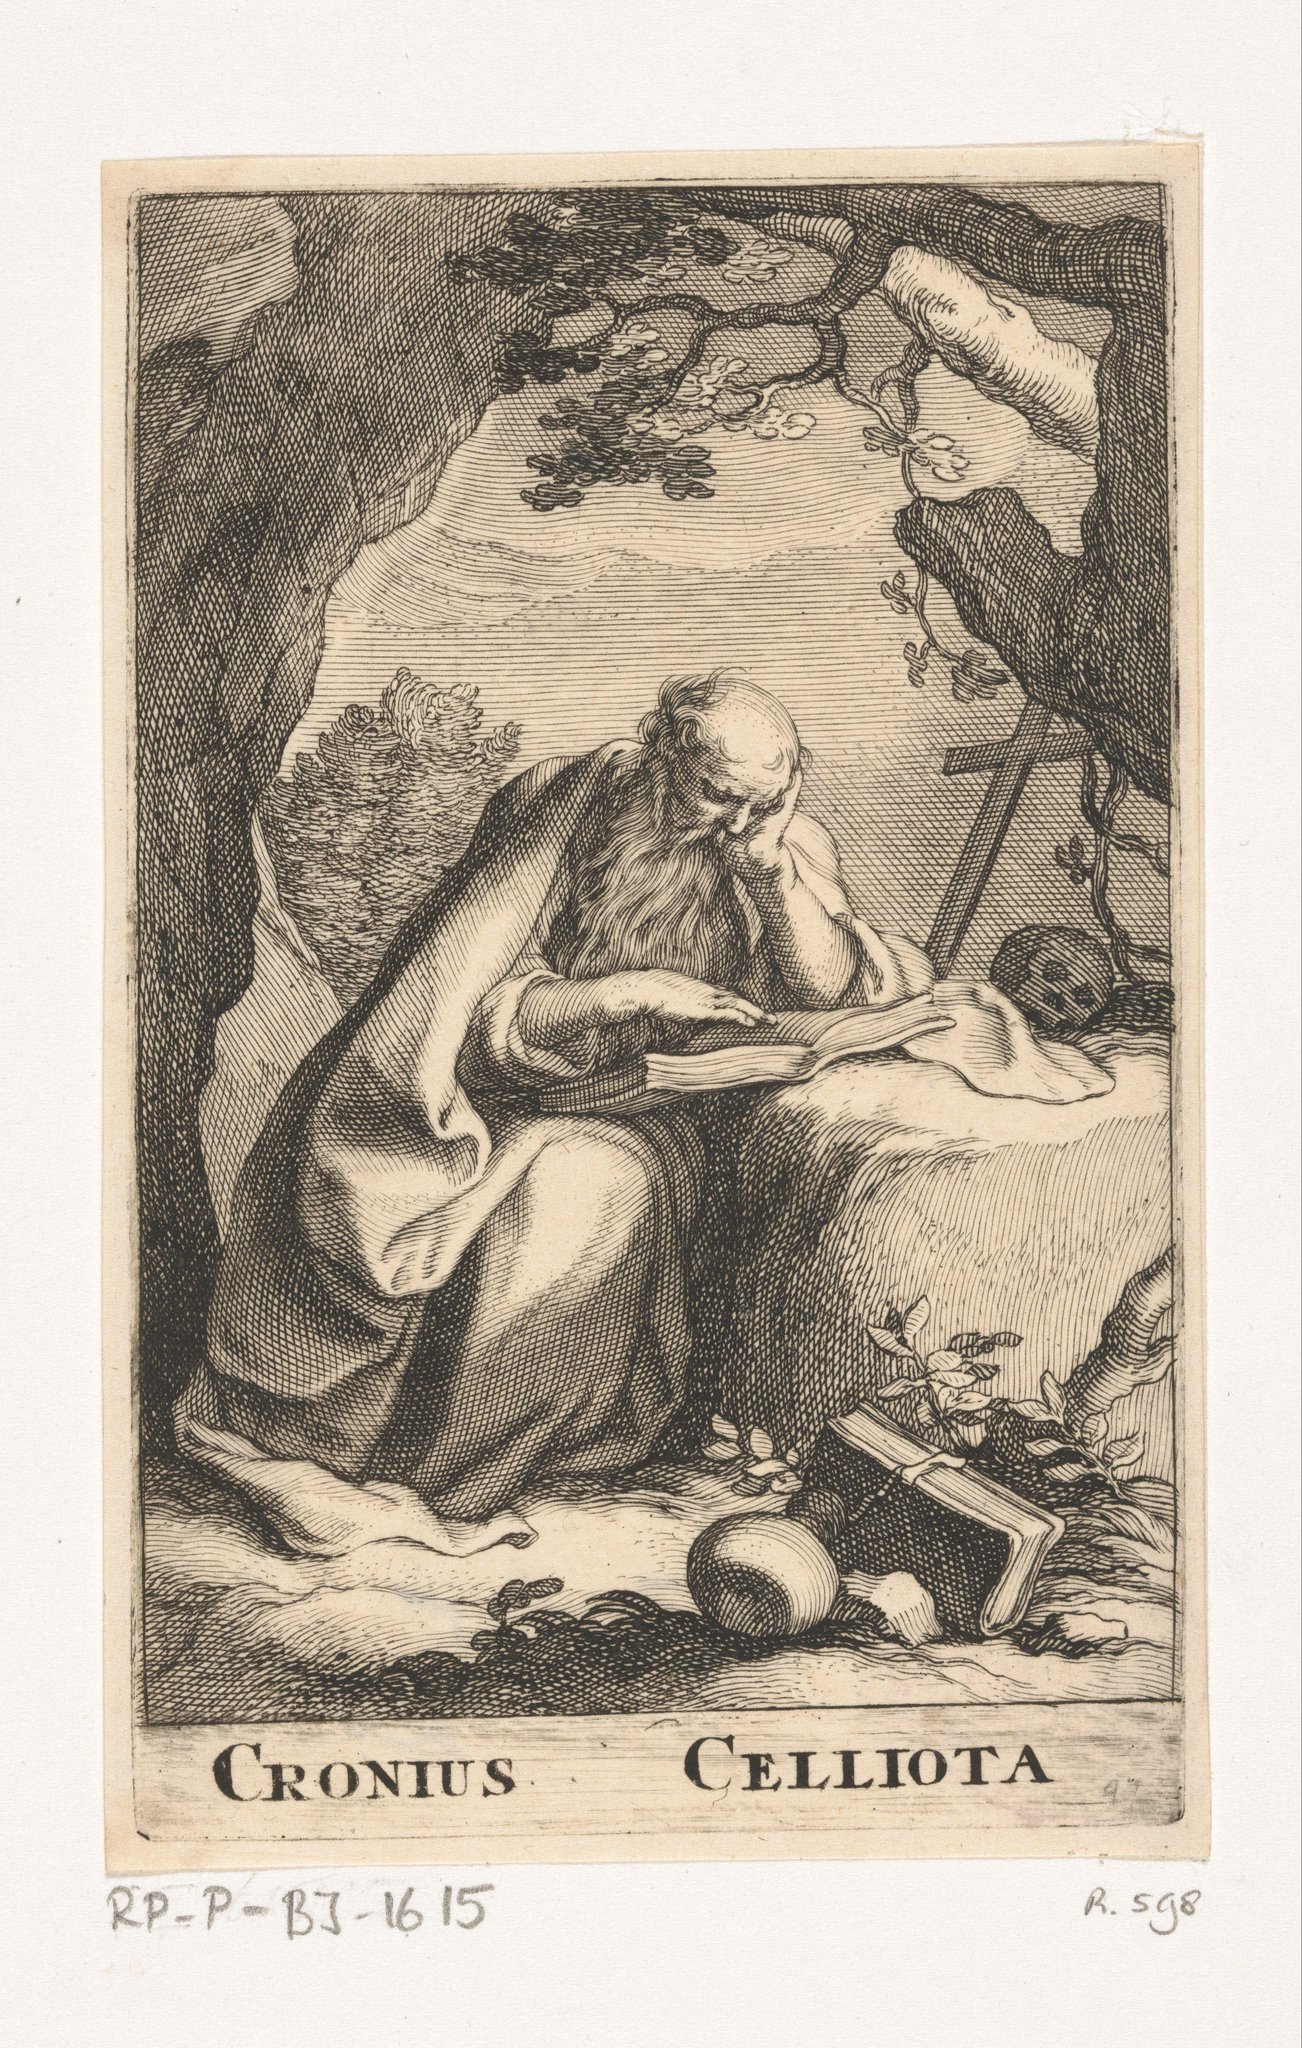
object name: print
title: Heilige Cronius van de Cellen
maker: frederick bloemaert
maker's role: print maker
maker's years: 1614-1669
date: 1636-1670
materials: paper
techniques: engraving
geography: utrecht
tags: male saints (cronius)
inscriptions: collector's mark: Lugt 240, number: ‘47’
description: De heilige Cronius ondersteunt met zijn hand zijn hoofd en leest een boek. Op tafel staat een kruisbeeld en ligt een schedel. Prent uit een serie van 80 prenten en een titelprent met kluizenaars uit de 2e tot de 6e eeuw.